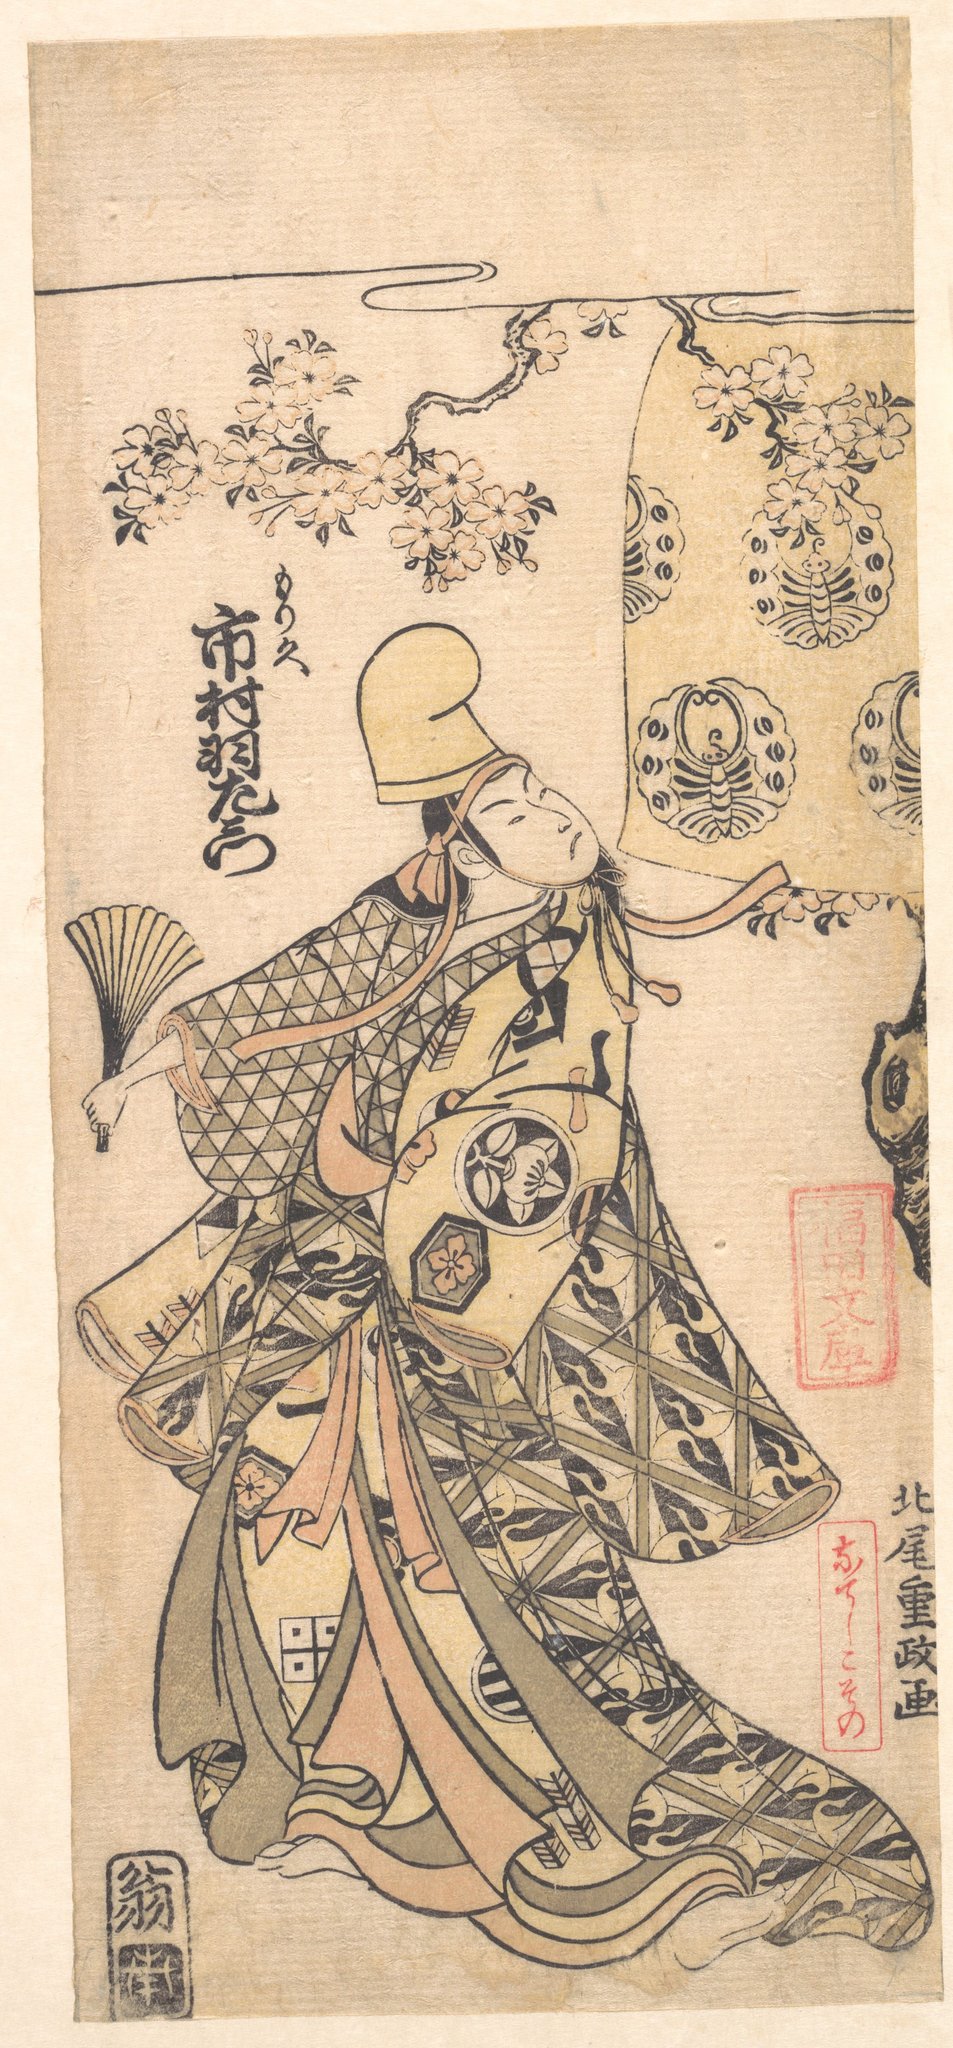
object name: print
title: The Actor Ichimura Uzaemon IX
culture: japanese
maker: kitao shigemasa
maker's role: artist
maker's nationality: japanese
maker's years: 1739-1820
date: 1769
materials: ink, paper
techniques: woodblock print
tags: flowers,actors